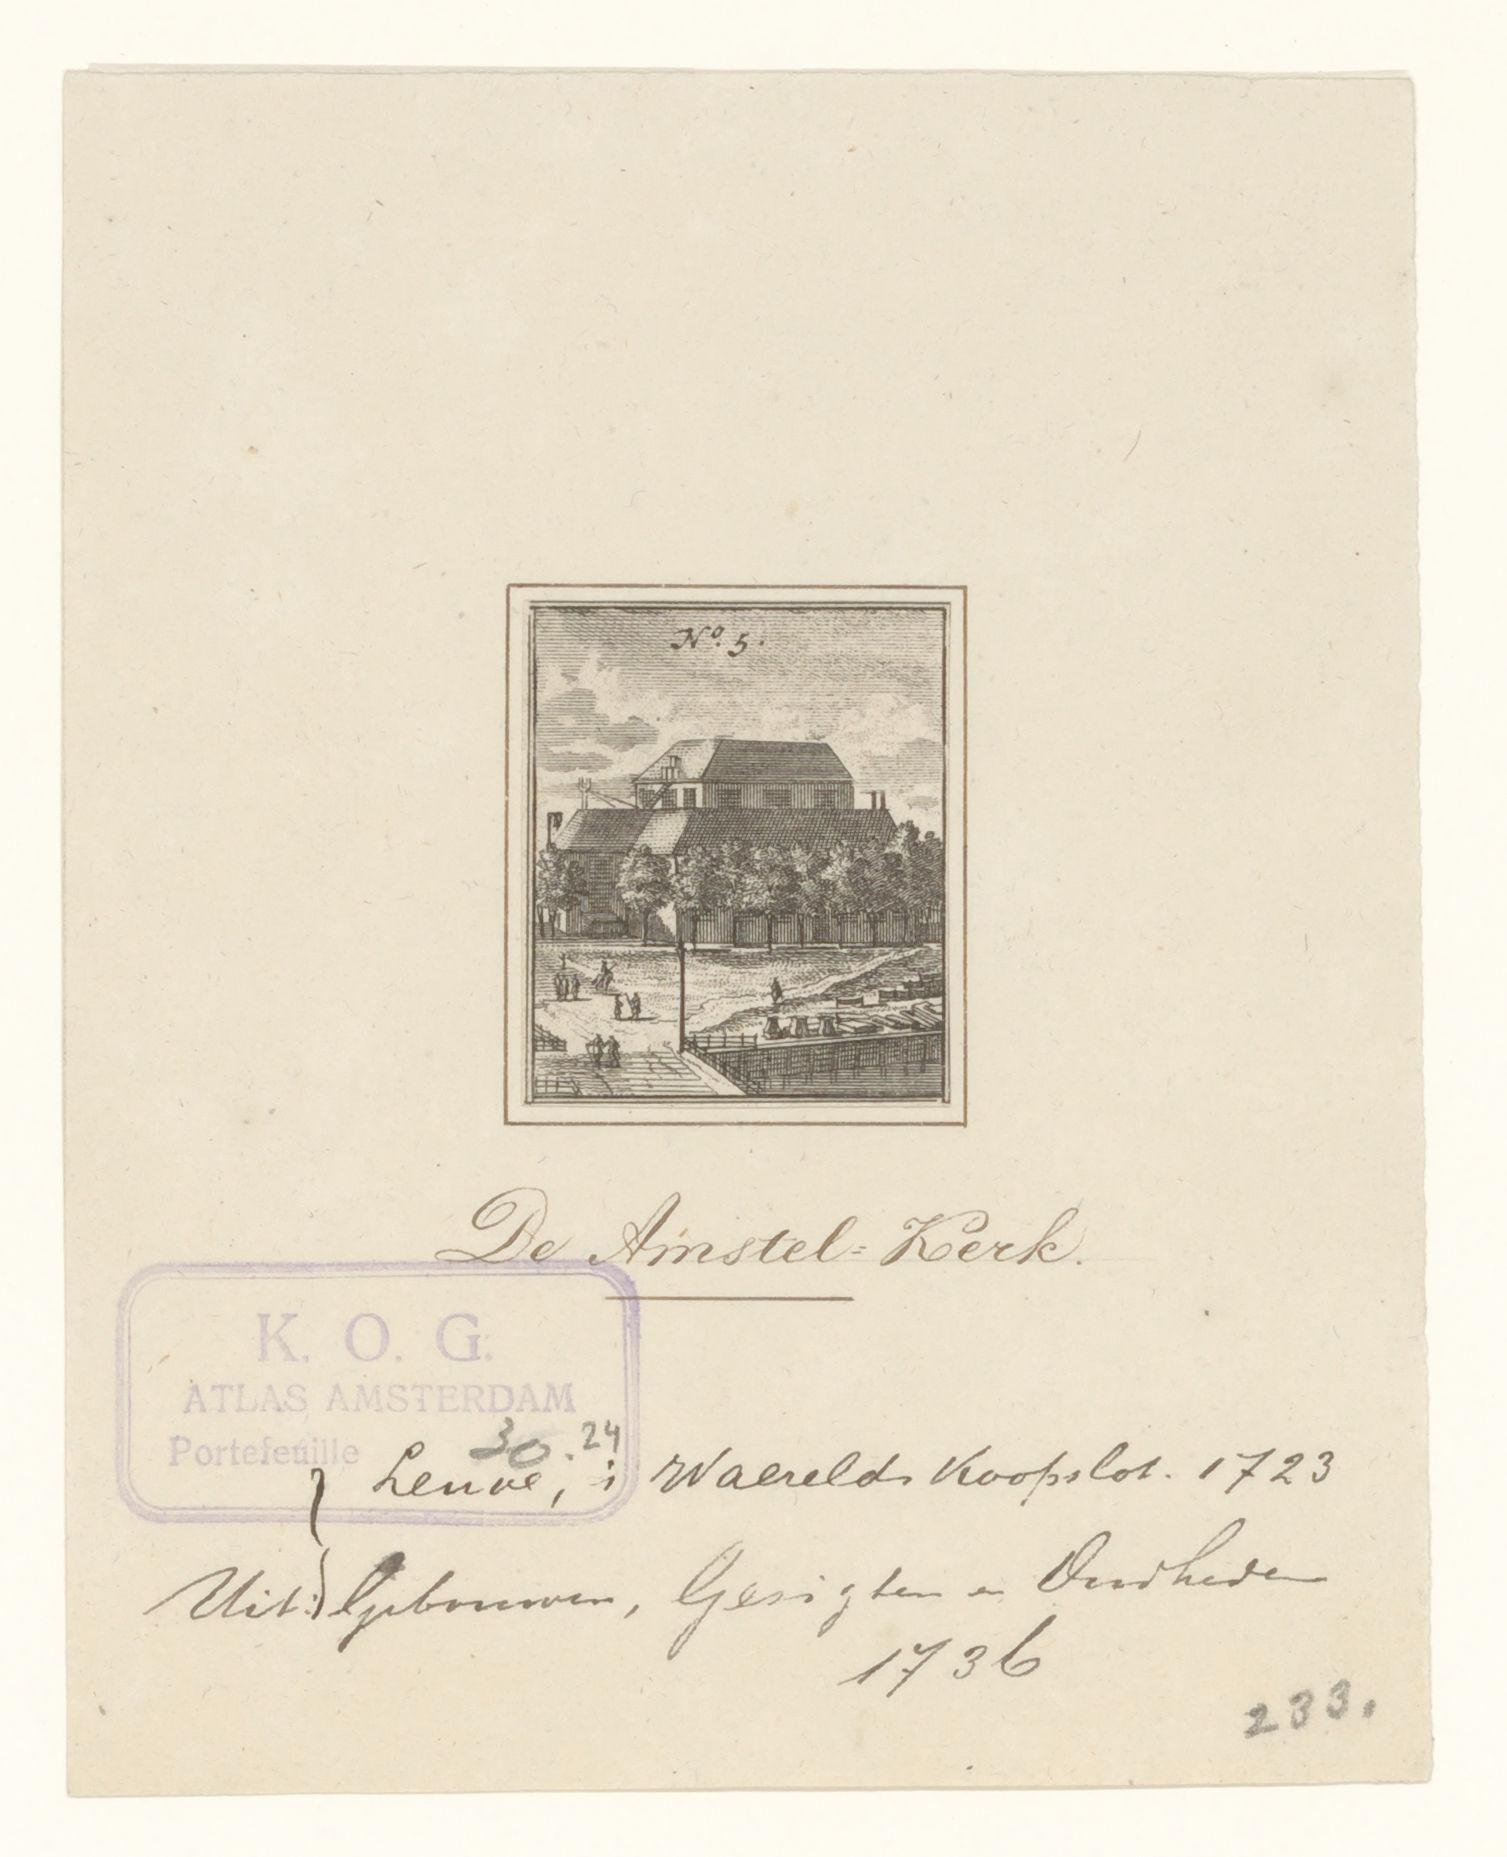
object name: book illustration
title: Gezicht op de Amstelkerk te Amsterdam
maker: adolf van der laan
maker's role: draughtsman, print maker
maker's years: 1689-1742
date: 1723-1744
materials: paper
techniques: etching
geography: northern netherlands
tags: church (exterior), city-view, and landscape with man-made constructions (+ city(-scape) with figures, staffage)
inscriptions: collector's mark: Lugt 1641b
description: Prent mogelijk uit: Leuven, Roeland van. 's Waerelds koopslot, of de Amsteldamsche beurs. Amsterdam: Jacobus Verheyde (I), 1723. Of uit: Leuven, Roeland van. 's Waerelds koopslot Of de Amsteldamse beurs. Amsterdam: Gerrit Bouman, 1730. Of uit: Gebouwen, Gezigten en Oudheden der Stad Amsterdam. Haarlem: Johannes Marshoorn, 1736. Of uit latere publicatie van 1741 of 1744.